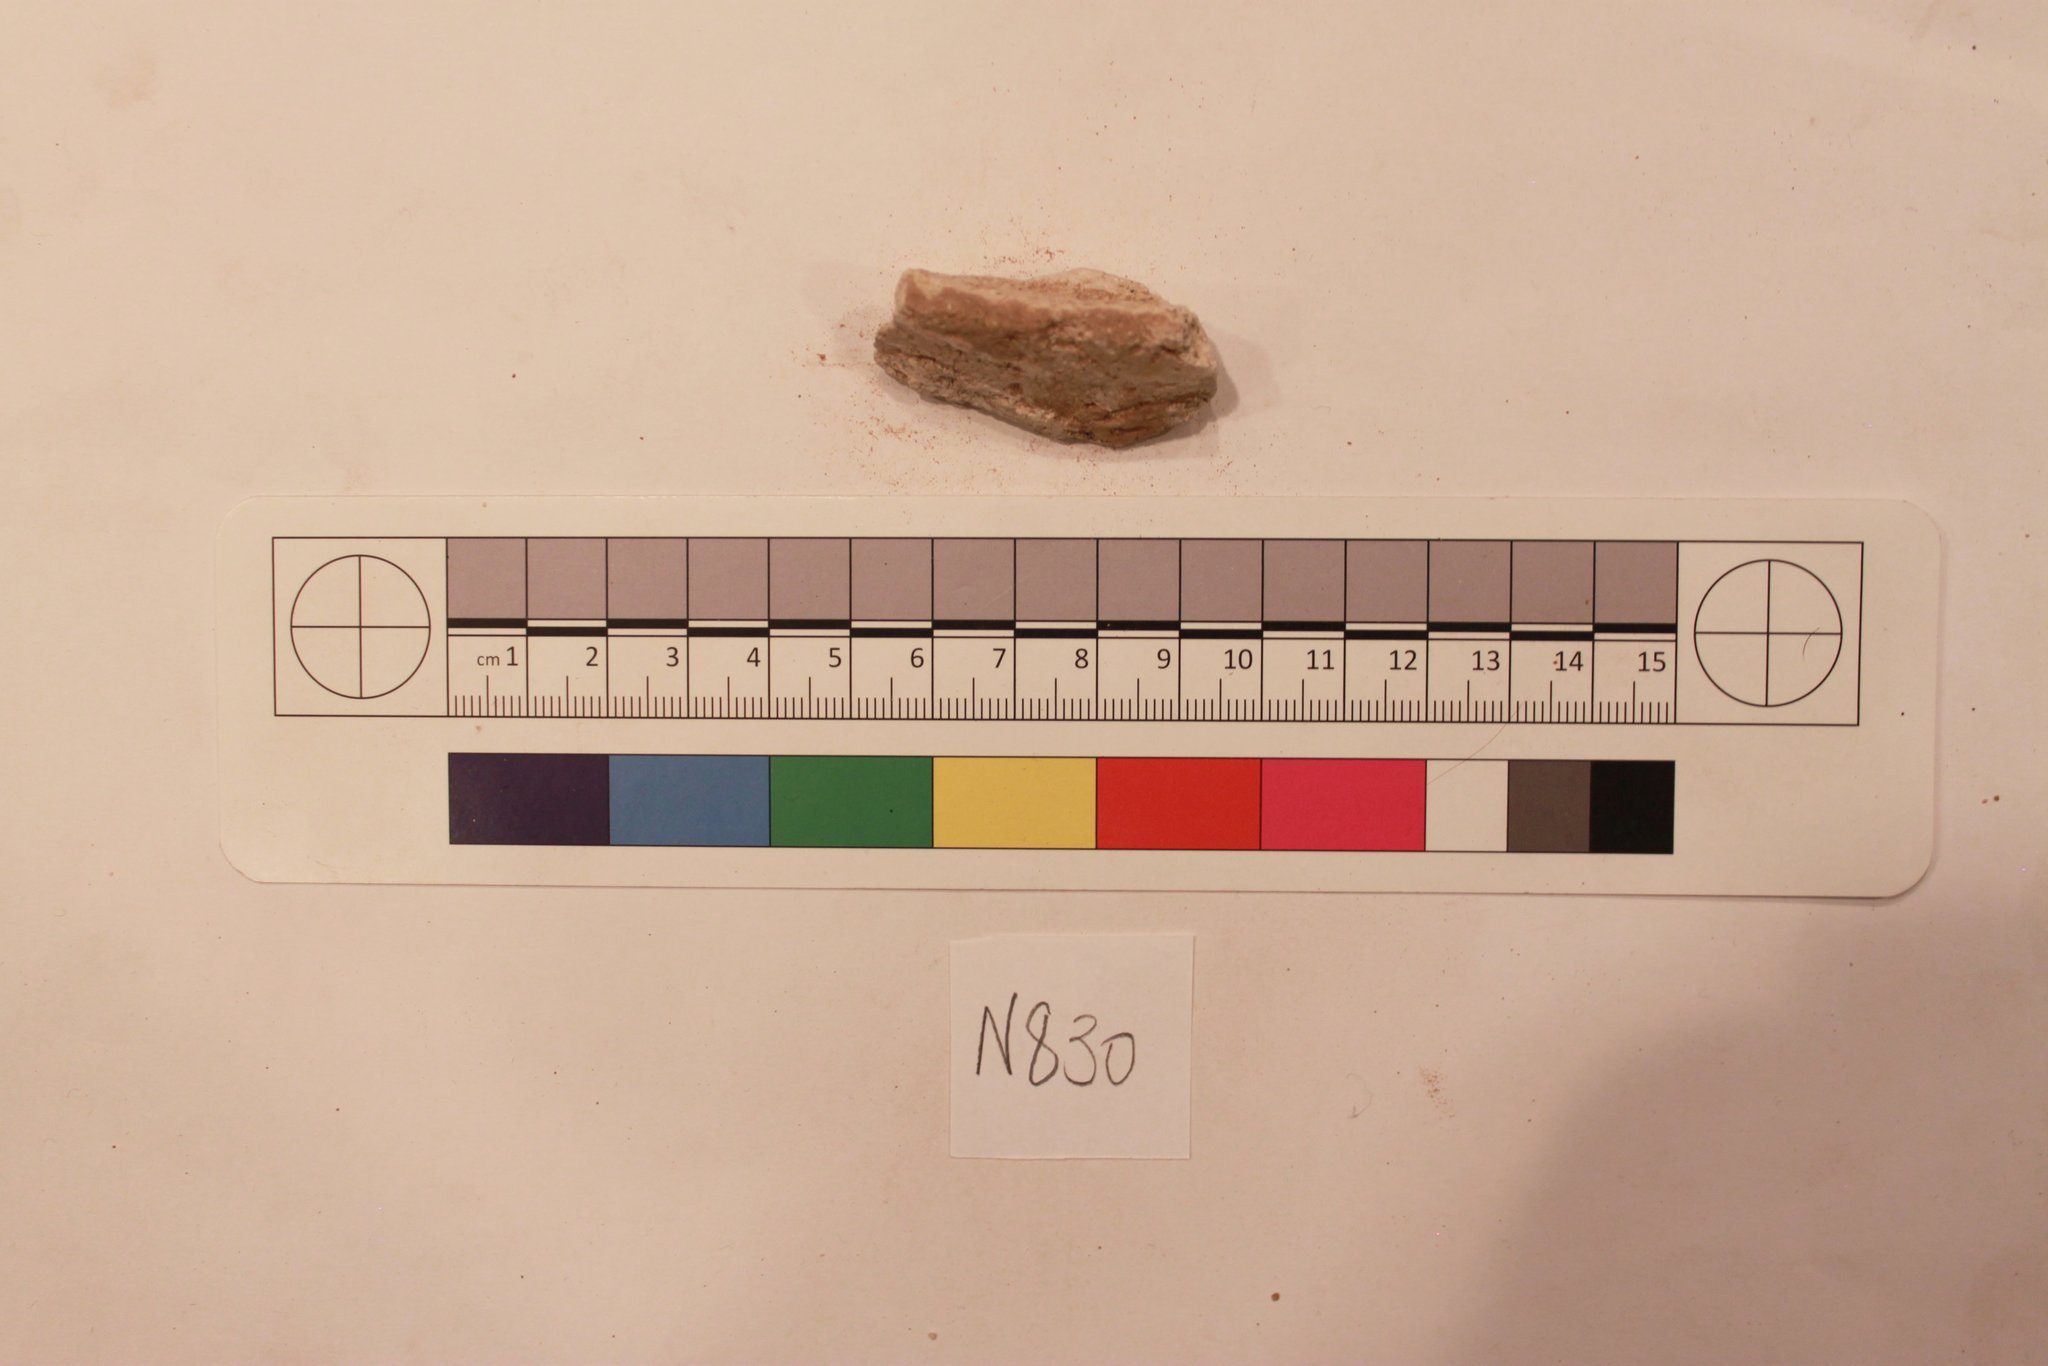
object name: fragment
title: Stucco Fragment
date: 701-1200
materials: plaster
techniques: carving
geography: iran